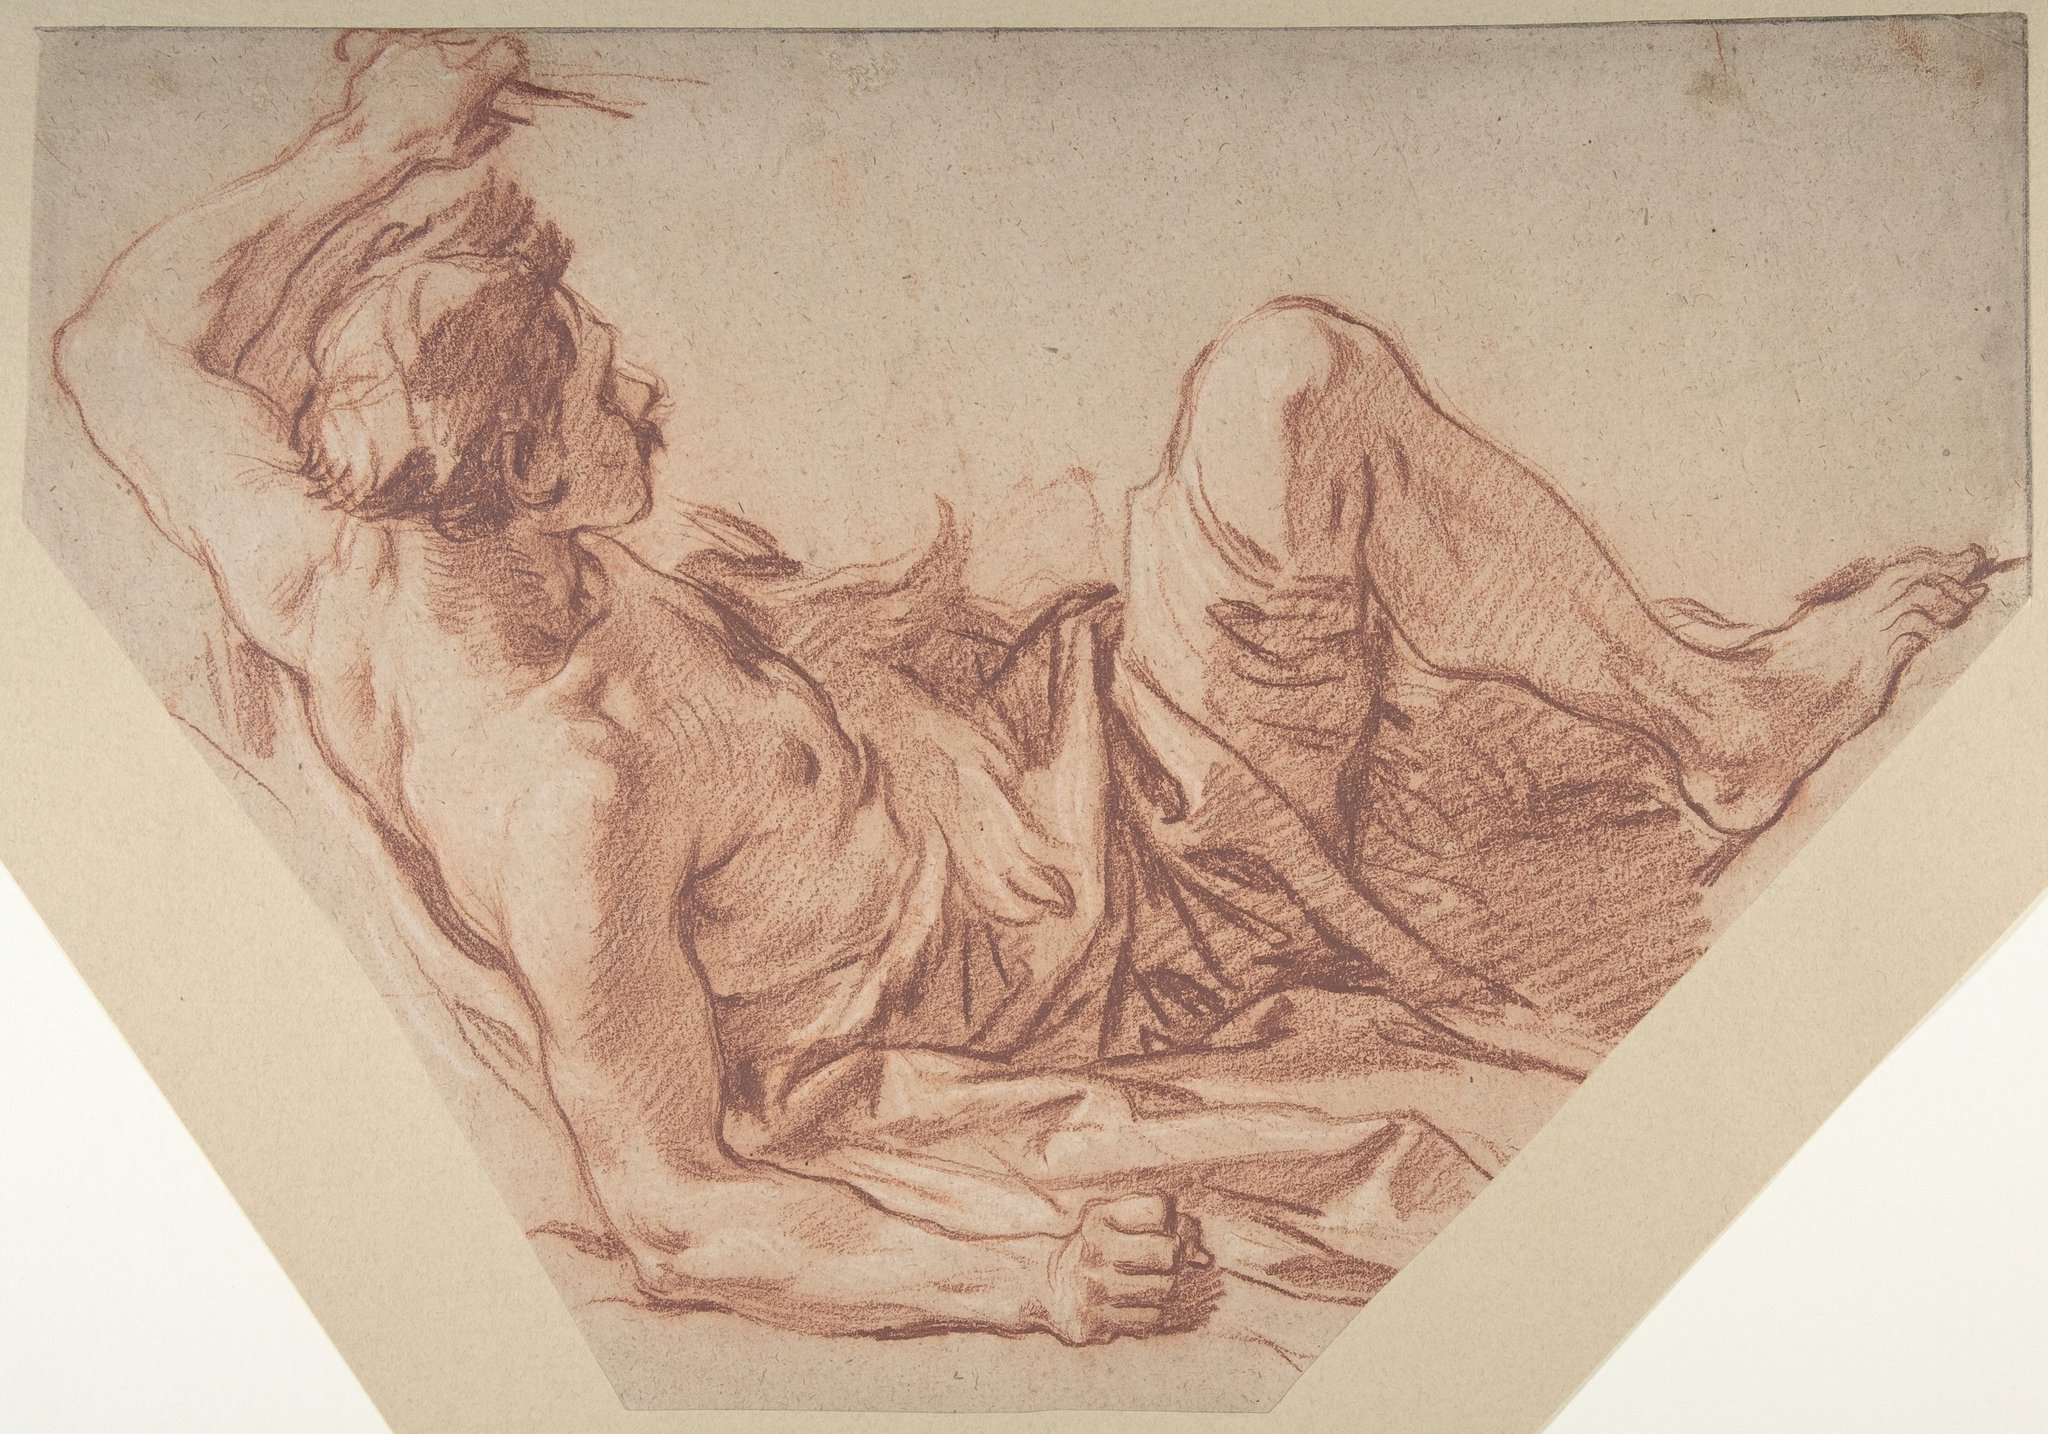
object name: drawing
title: Fallen Huntsman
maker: françois boucher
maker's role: artist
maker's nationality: french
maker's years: 1703-1770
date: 1736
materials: chalk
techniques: heightening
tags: men